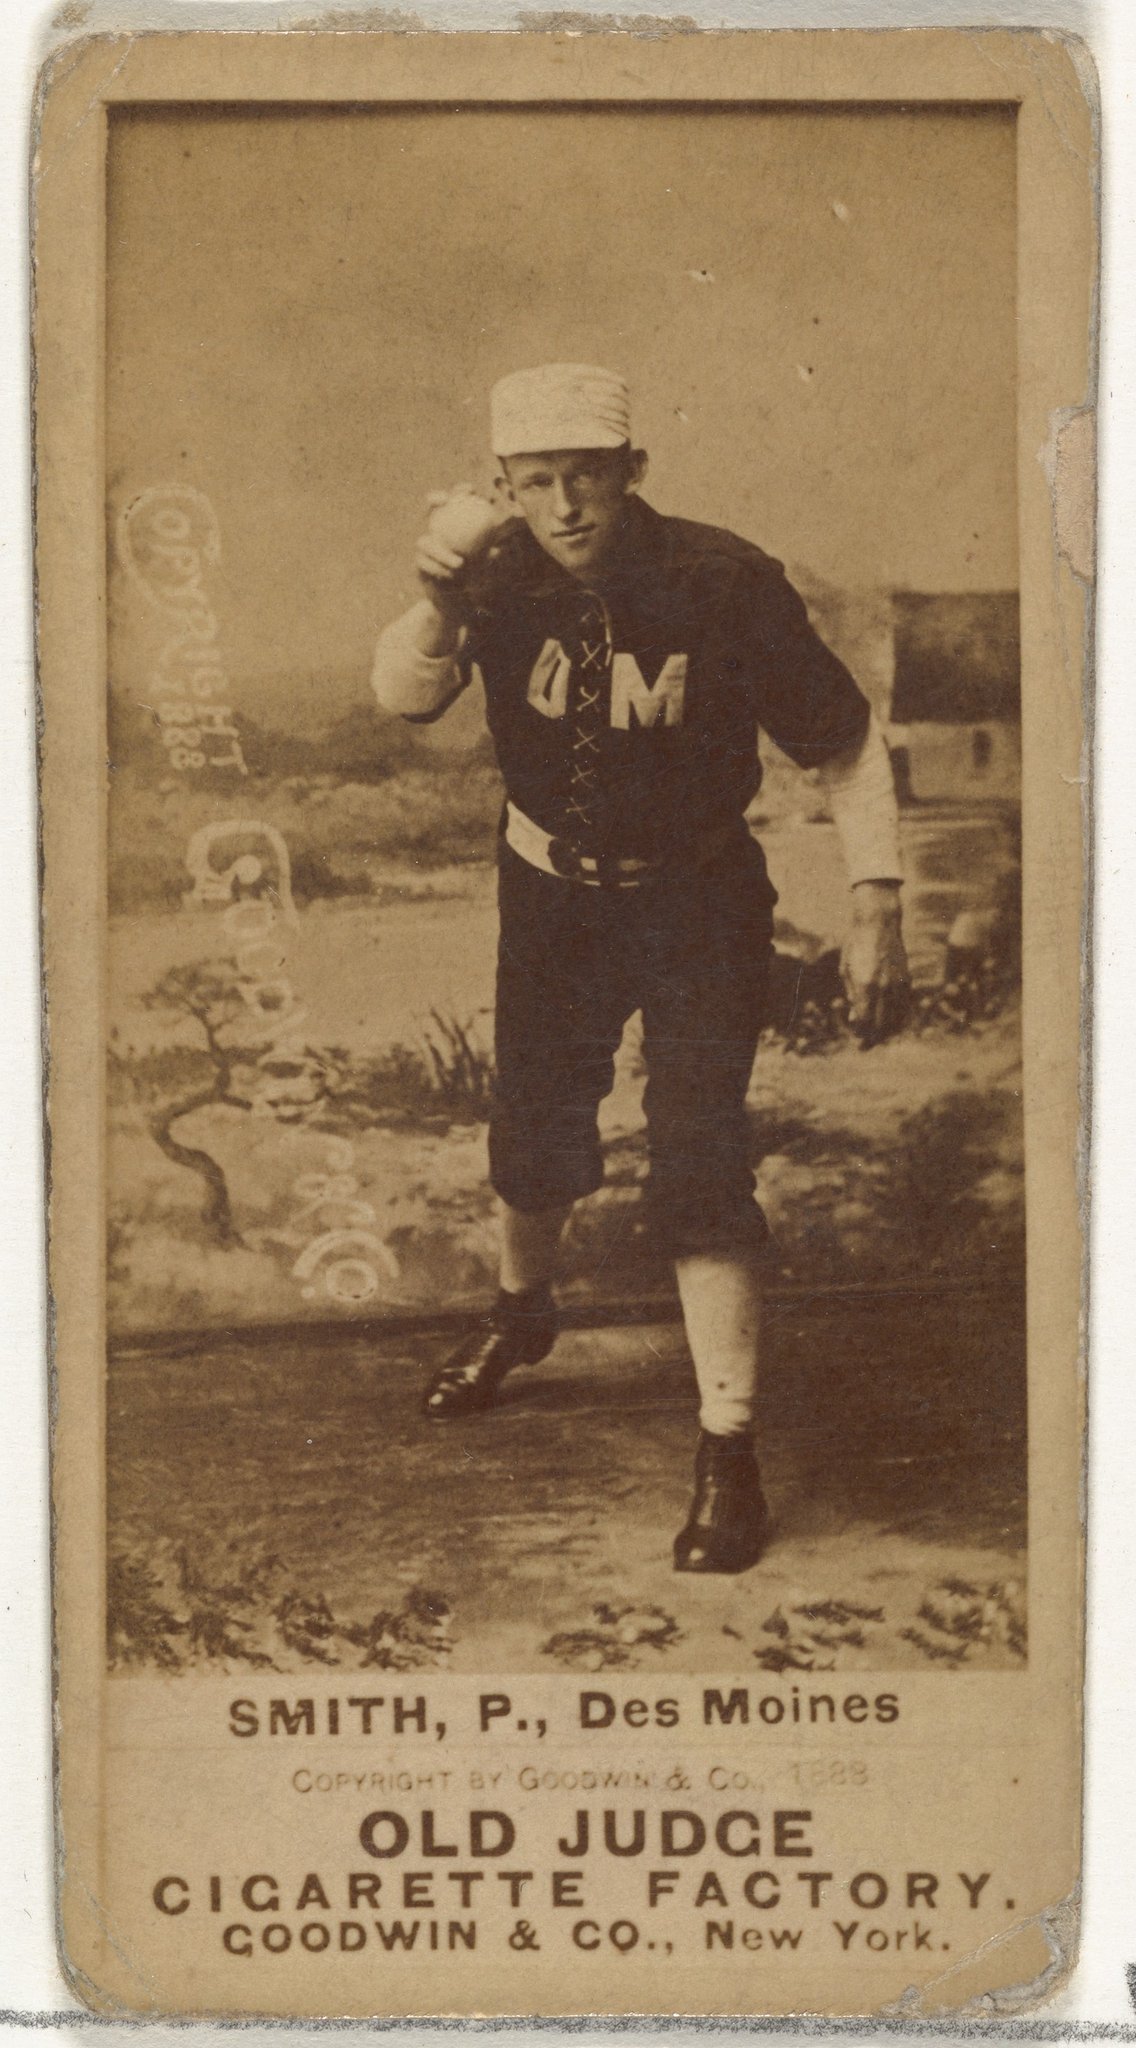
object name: baseball card, photograph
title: Frederick C. "Fred" Smith, Pitcher, Des Moines Prohibitionists, from the Old Judge series (N172) for Old Judge Cigarettes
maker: goodwin & company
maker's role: publisher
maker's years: 1850-1950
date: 1888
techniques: albumen silver print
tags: men,portraits,baseball,athletes